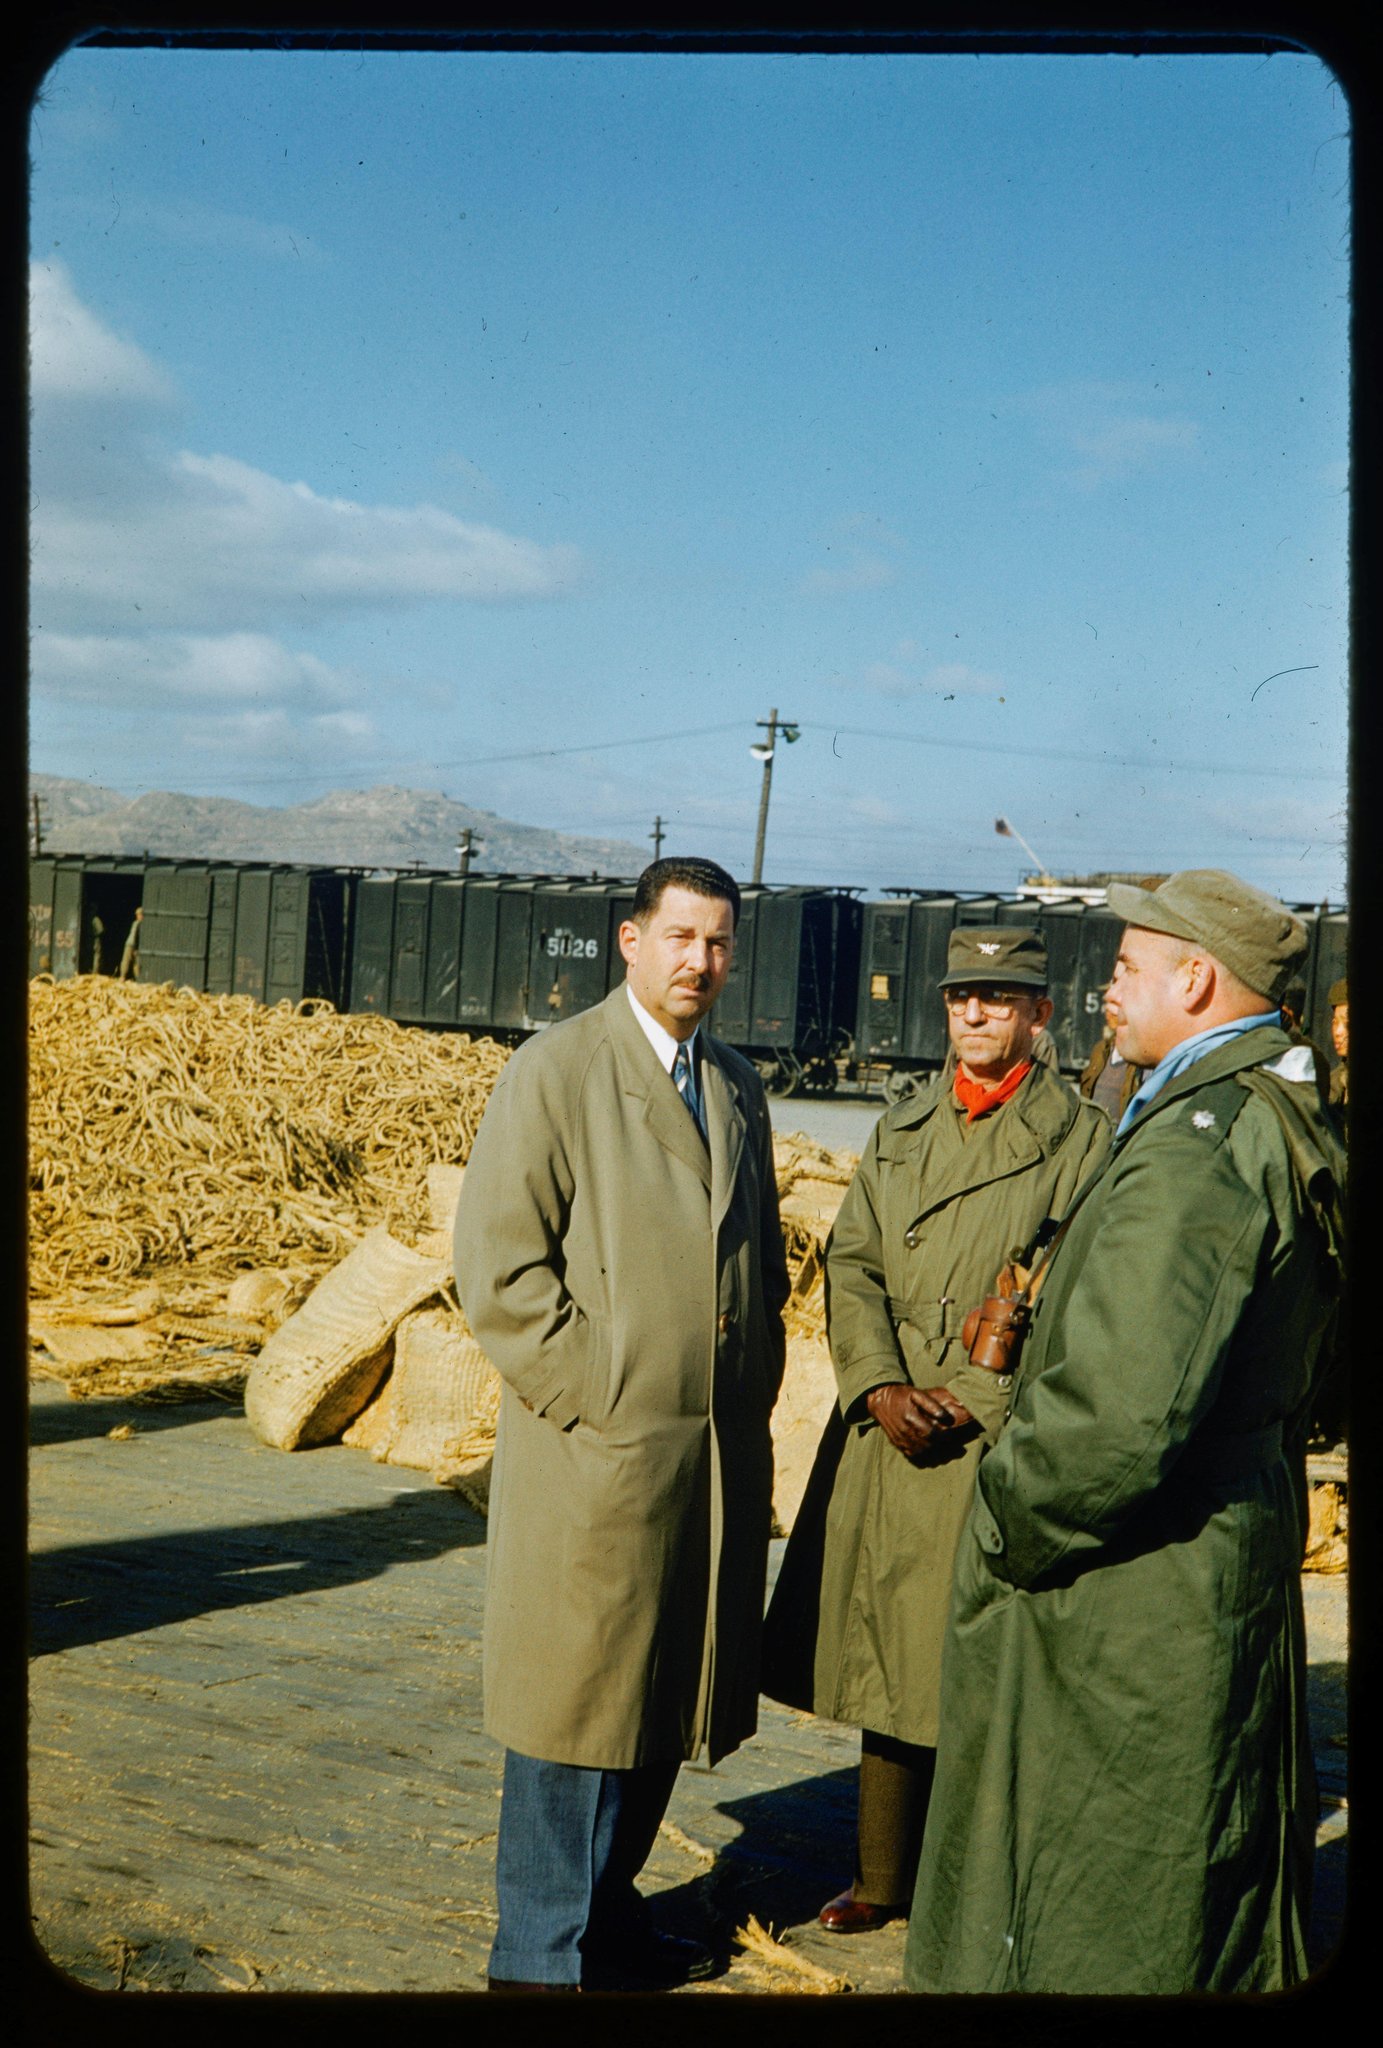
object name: color slide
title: Oorlog in Korea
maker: david ketel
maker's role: diplomaat, sinoloog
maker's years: 1913-2008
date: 1951-1953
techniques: slide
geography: korea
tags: united nations